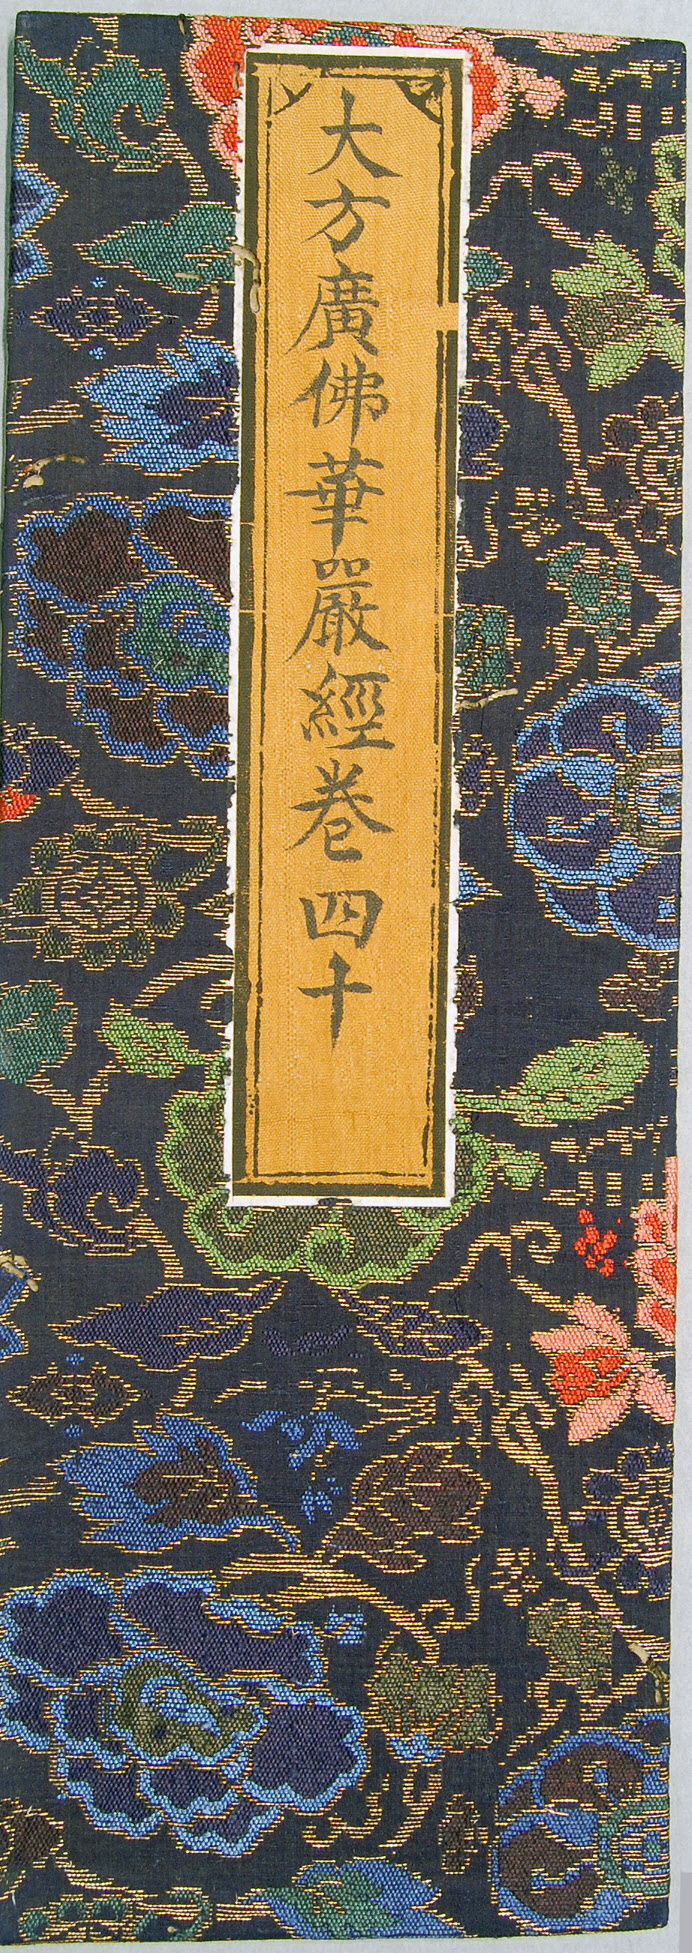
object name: sutra cover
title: Sutra cover with flower scrolls and auspicious symbols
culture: chinese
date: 1501-1600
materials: metal thread, silk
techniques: patterning